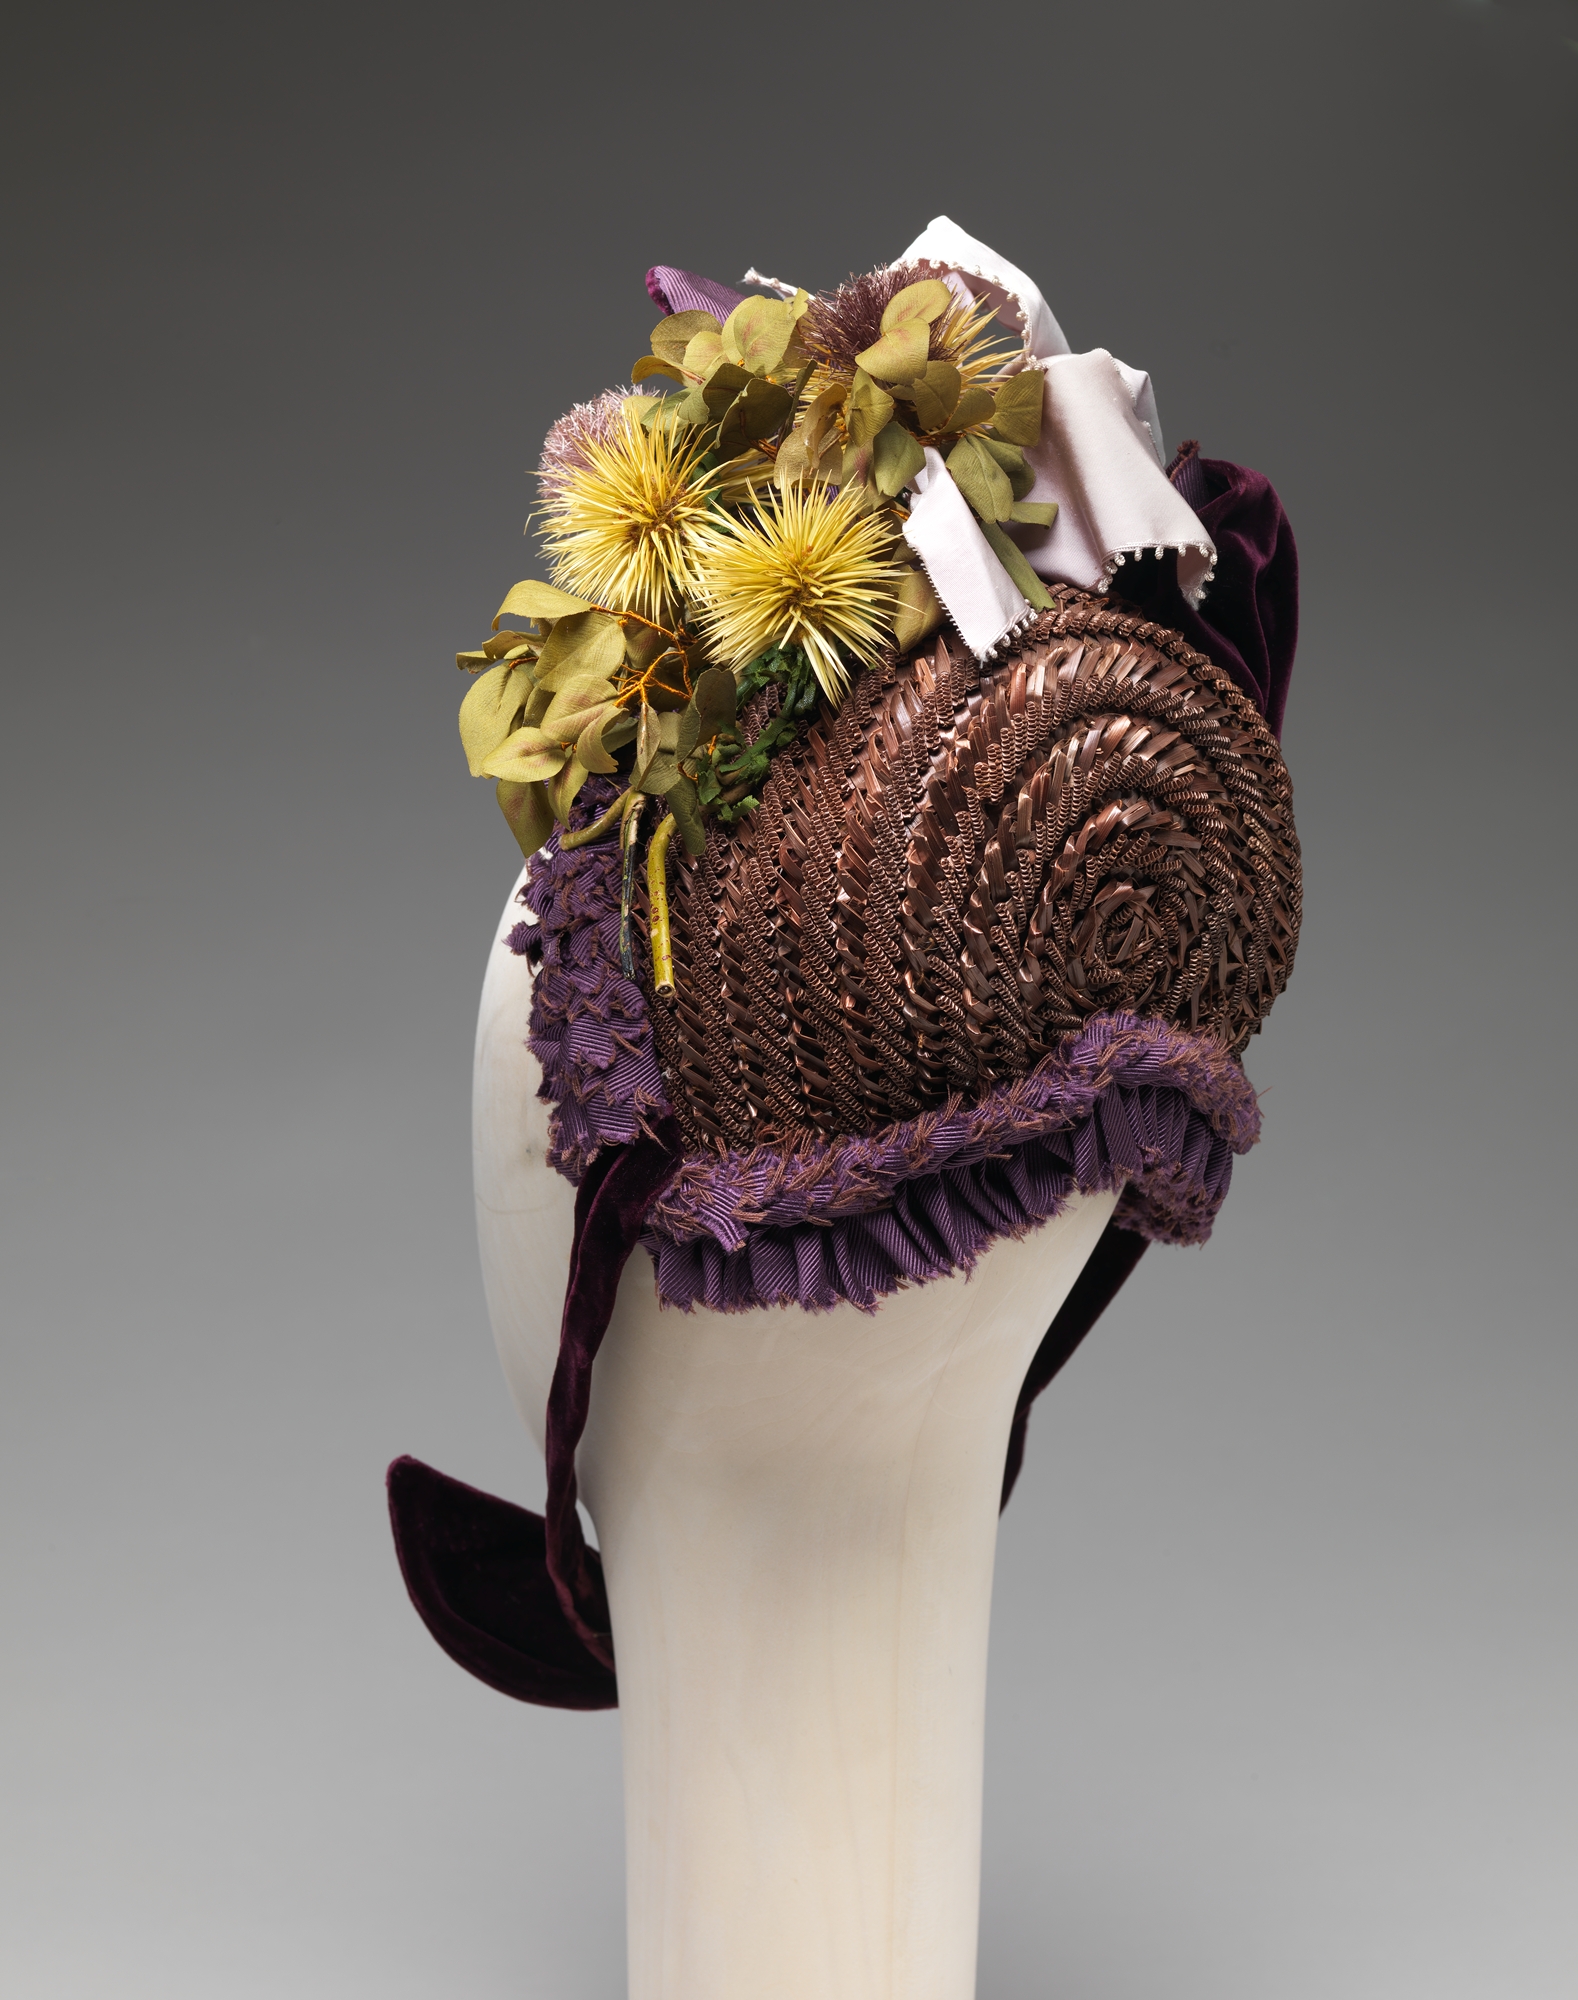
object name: bonnet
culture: french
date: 1887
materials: silk, fiber